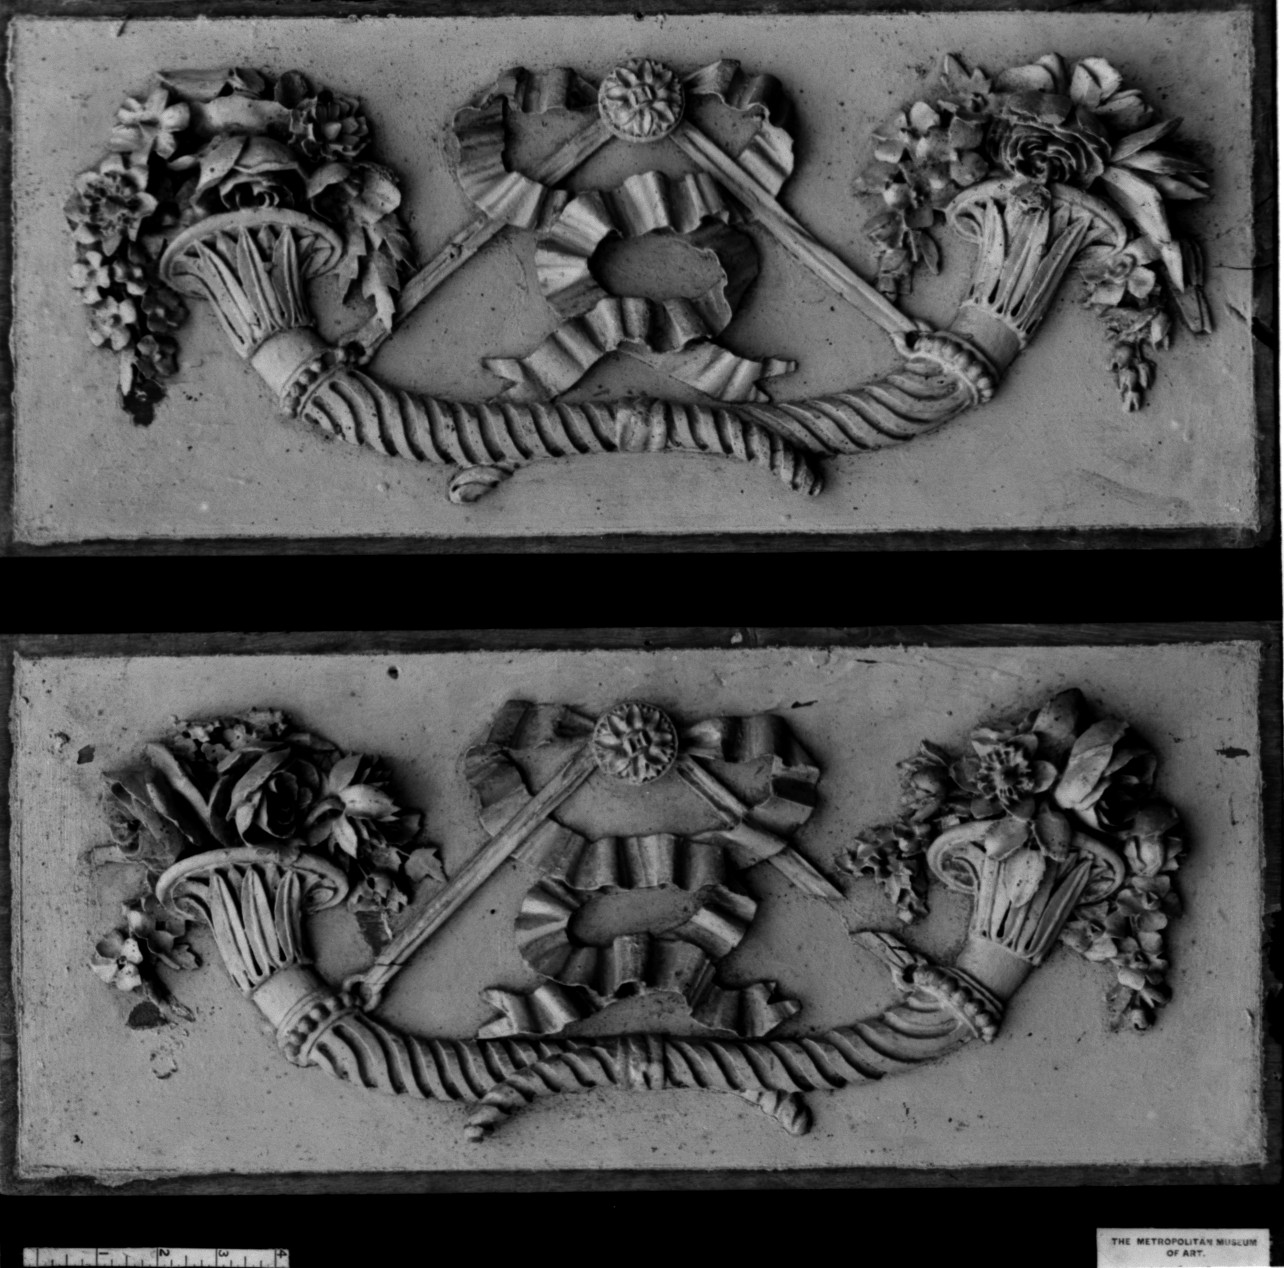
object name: panel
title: Pair of panels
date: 1701-1800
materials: wood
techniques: carving, painting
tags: cornucopia